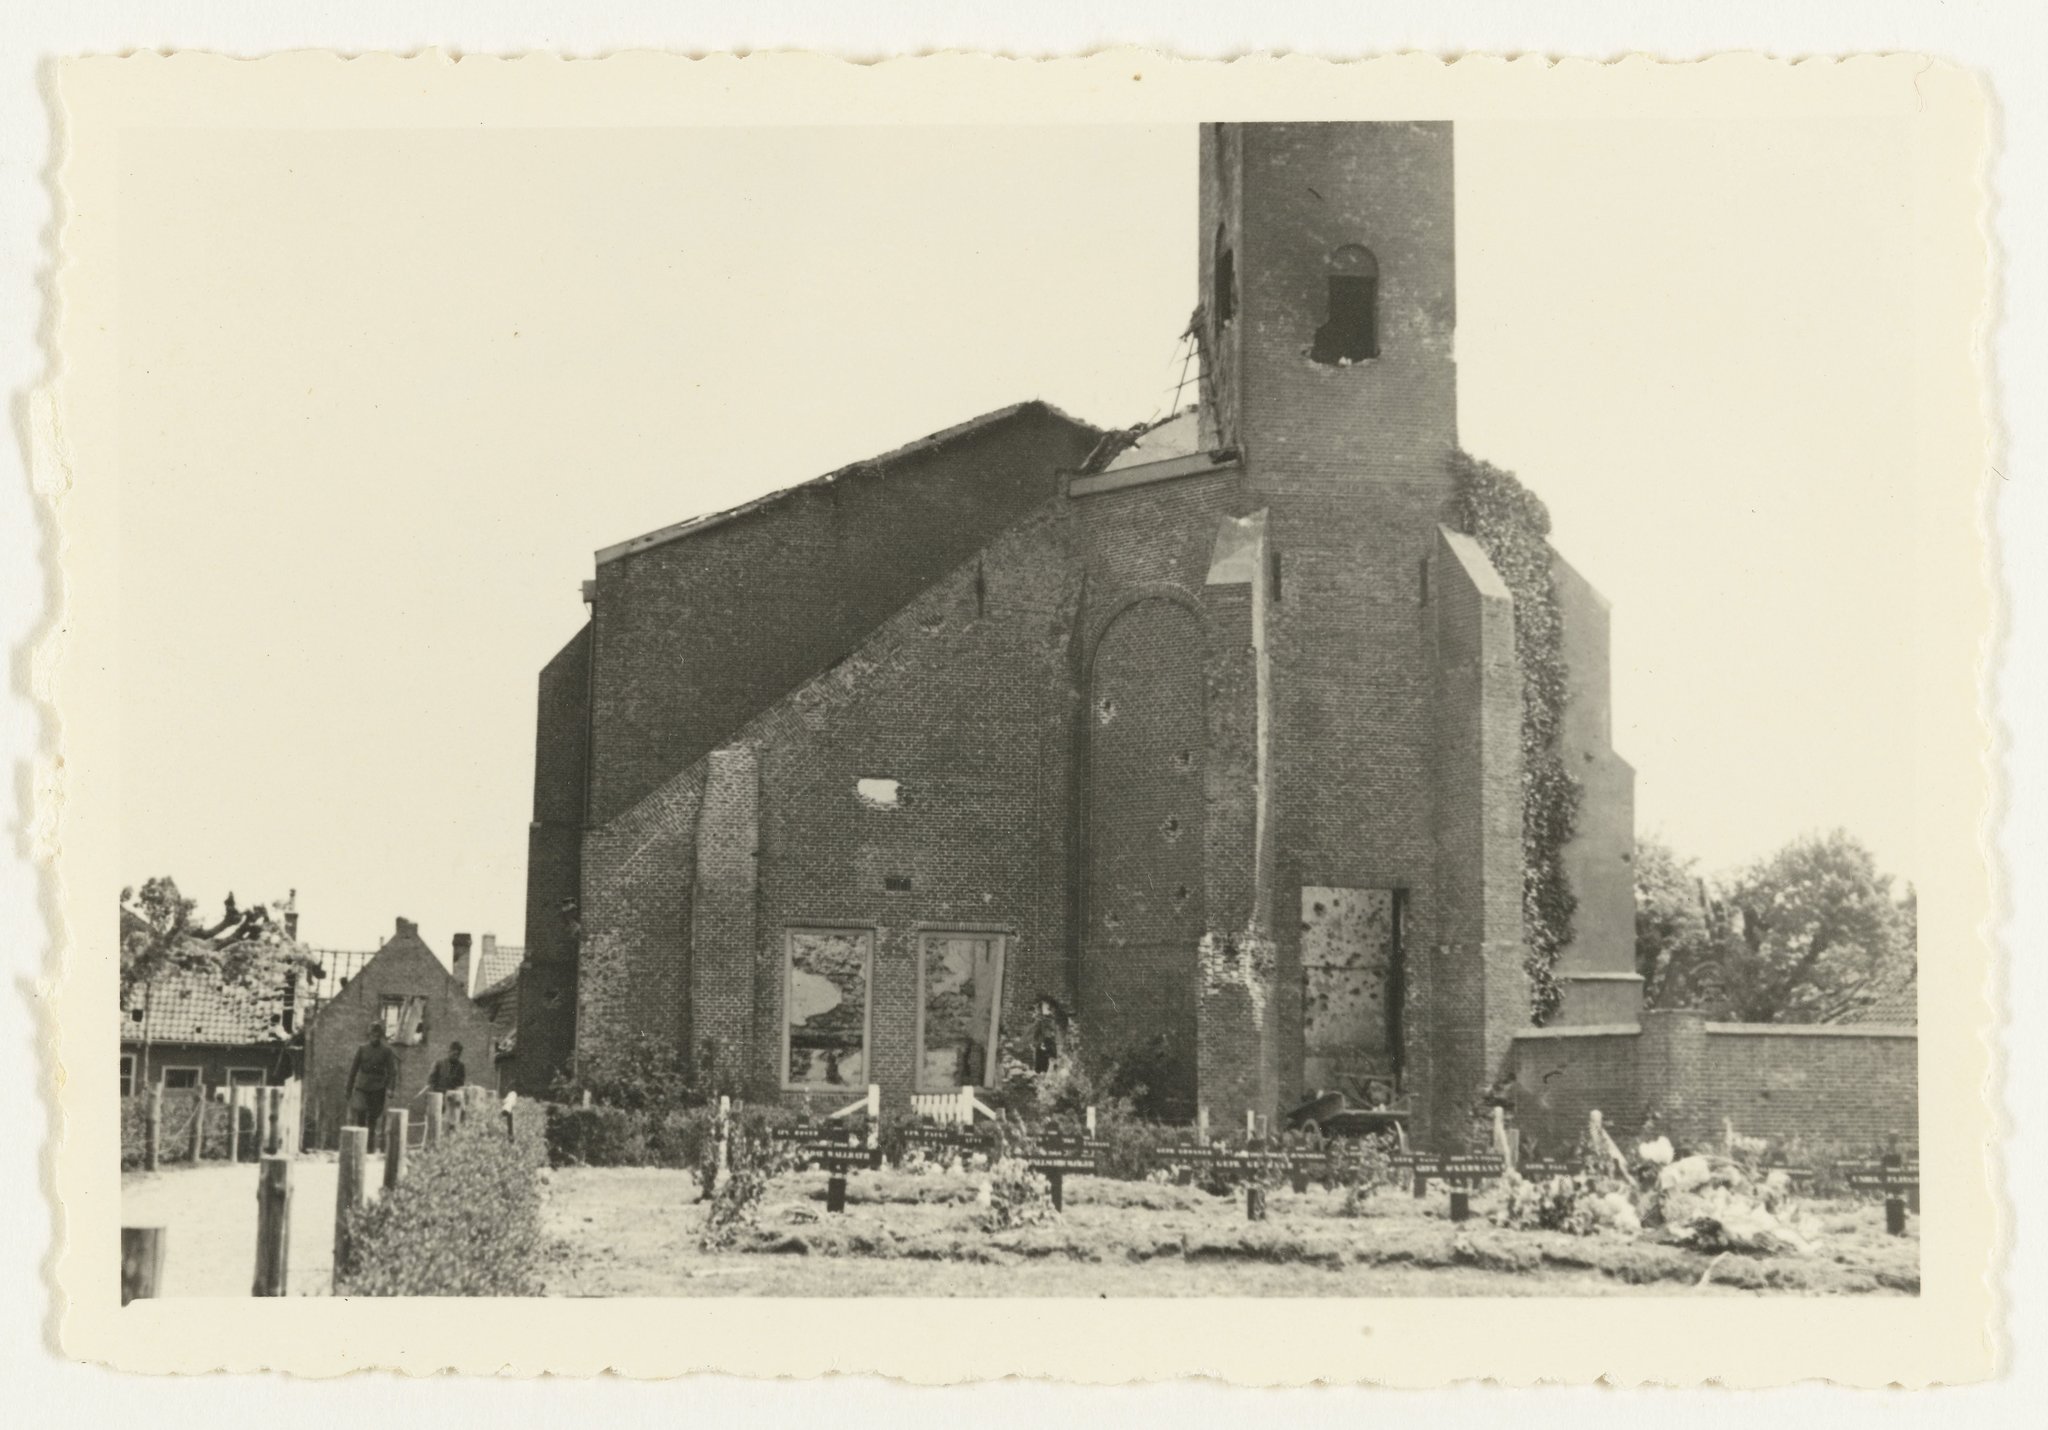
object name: photograph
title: Begraafplaats Duitse militairen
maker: Anonymous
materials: photographic support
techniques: gelatin silver print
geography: valkenburg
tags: churchyard, cemetery, occupation ~ war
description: Een begraafplaats met Duitse militairen aan de voet van de ruine van een kerk. Achterop staat: Valkenburg, Holland, die kirche mit dem.....Ehrenfriedhof